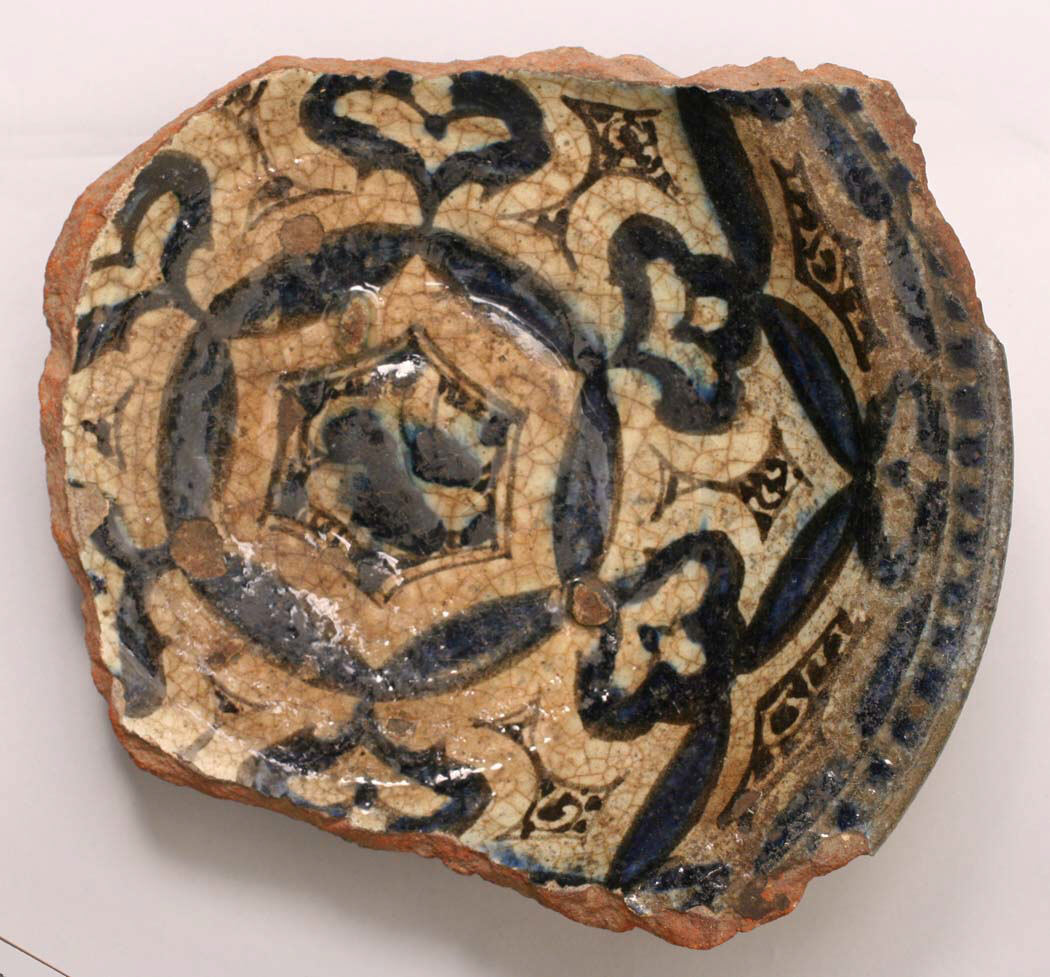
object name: fragment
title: Fragment of a Bowl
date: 1401-1500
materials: earthenware, glaze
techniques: underglaze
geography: egypt